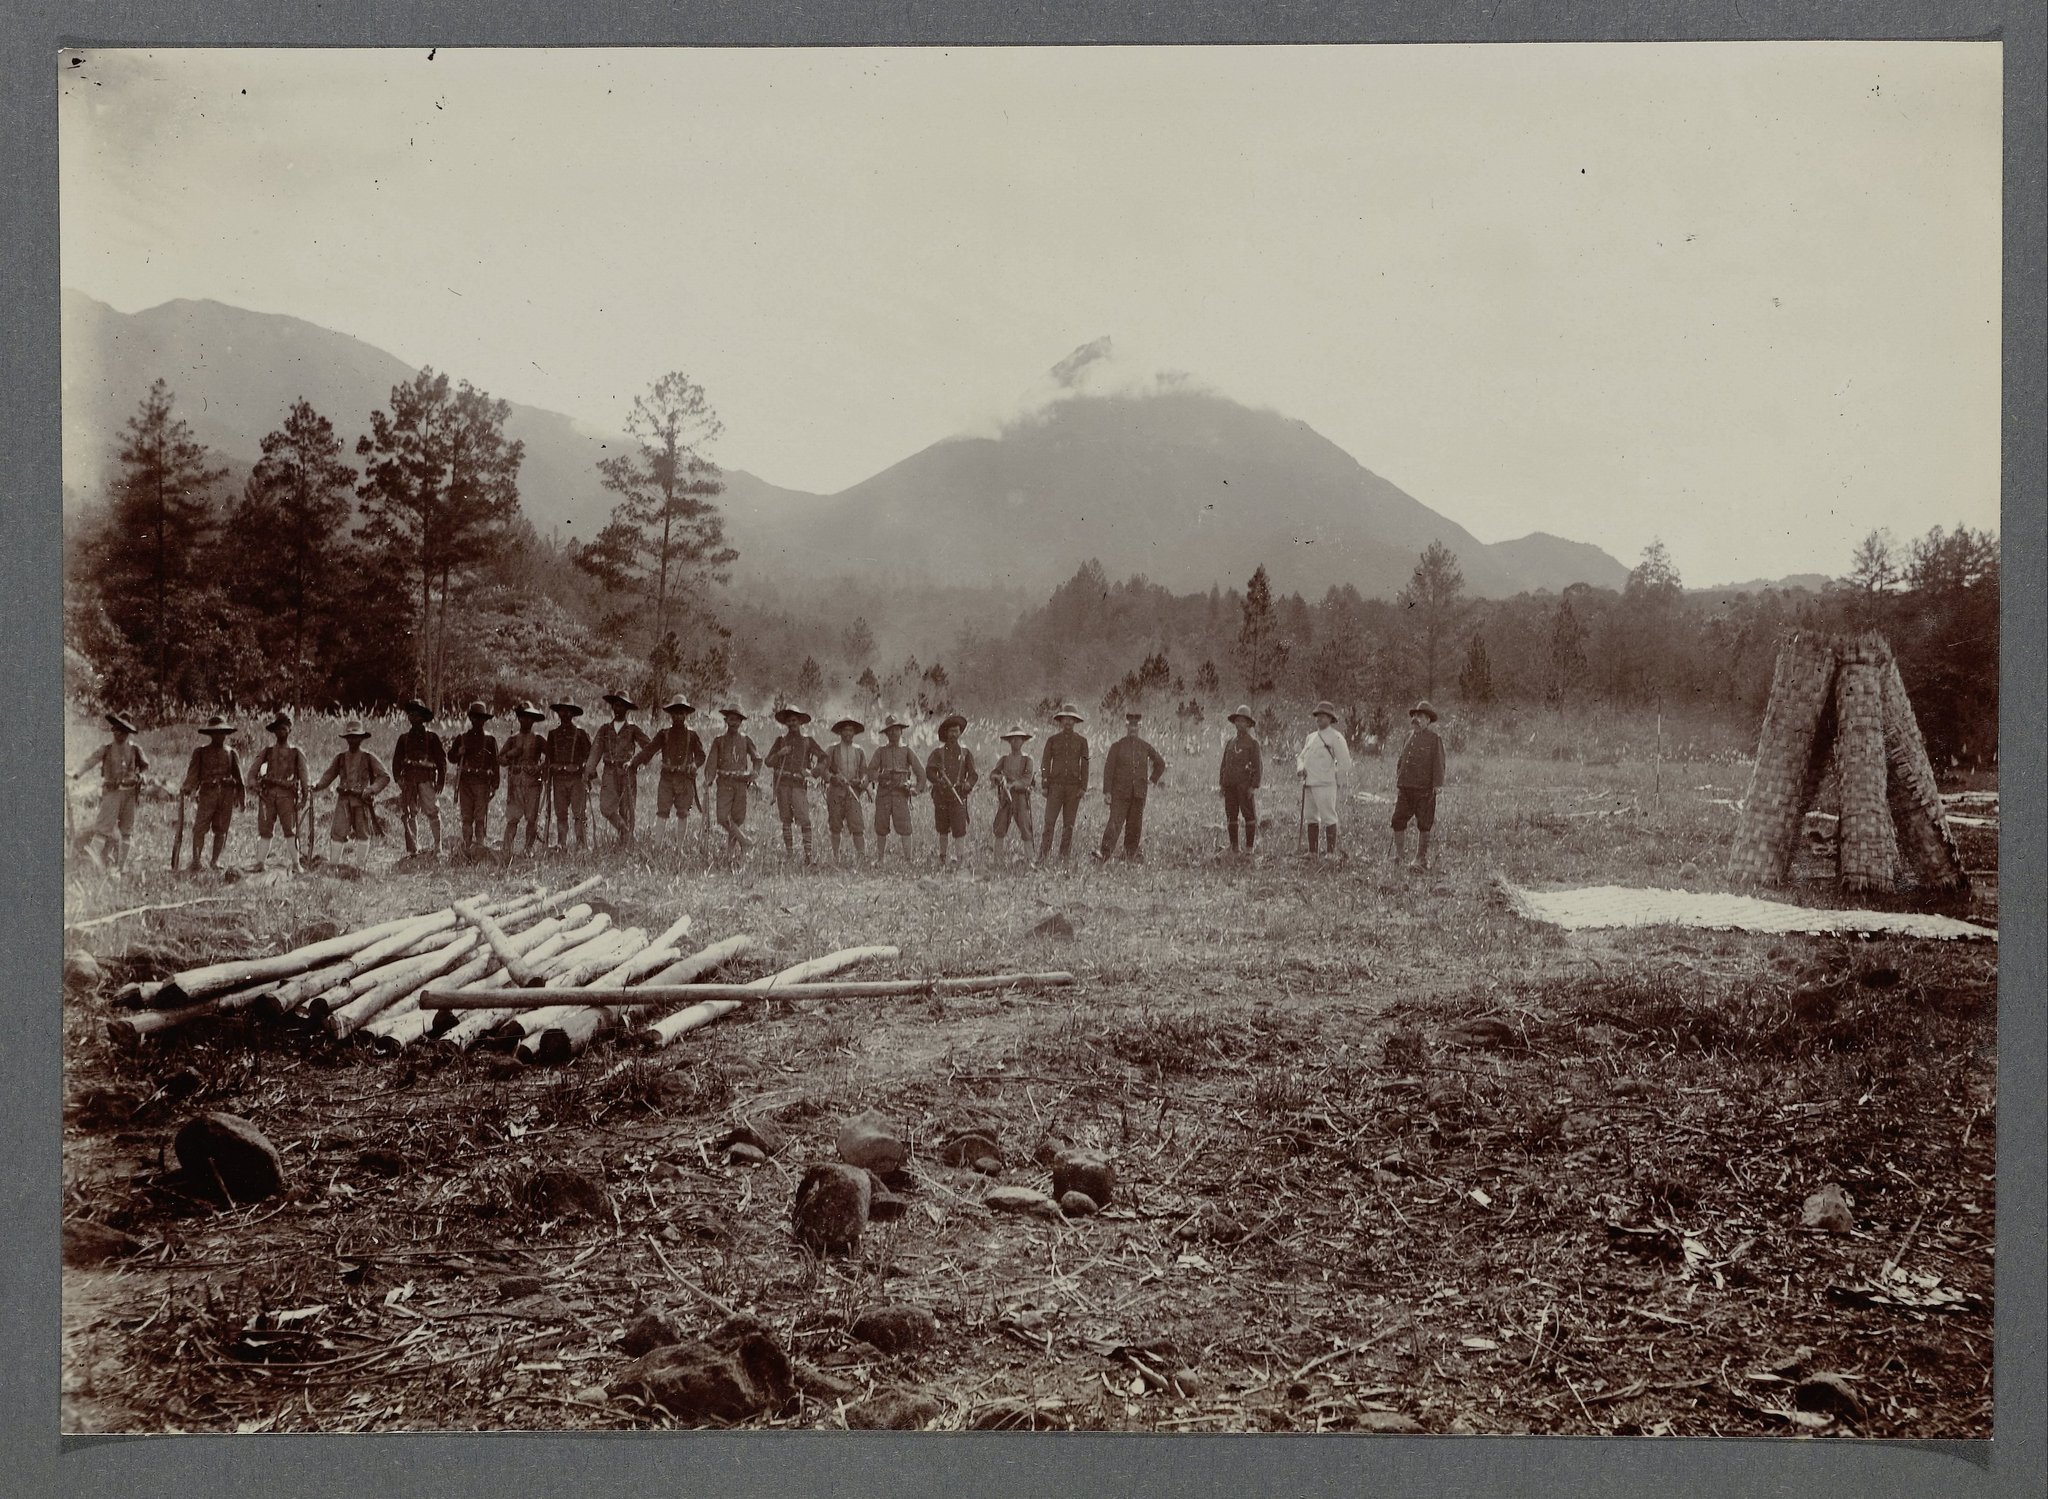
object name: photograph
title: Soldiers Posing in a Row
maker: Anonymous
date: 1910-1913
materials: photographic support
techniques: gelatin silver print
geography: north sumatra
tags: arnhem, albertus dominicus laman trip, building activities, military service, traffic by road or path with motor-vehicle, landscapes in tropical and sub-tropical regions, road, path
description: Na de expedities naar de Gajo- en Alaslanden o.l.v. Van Daalen (eerste tocht in 1901), werd hij in 1903 belast met voorbereiding van permanente vestiging van Nederlands gezag. Aanleg van een weg van de Noordkust naar het binnenland was hierbij van groot belang. Deze zgn. Gajoweg werd aangelegd tussen 1903 en 1914, van Bireuen aan de kust naar Takinguen aan het bergmeer Danau Lauttawar, totale lengte 104 km.